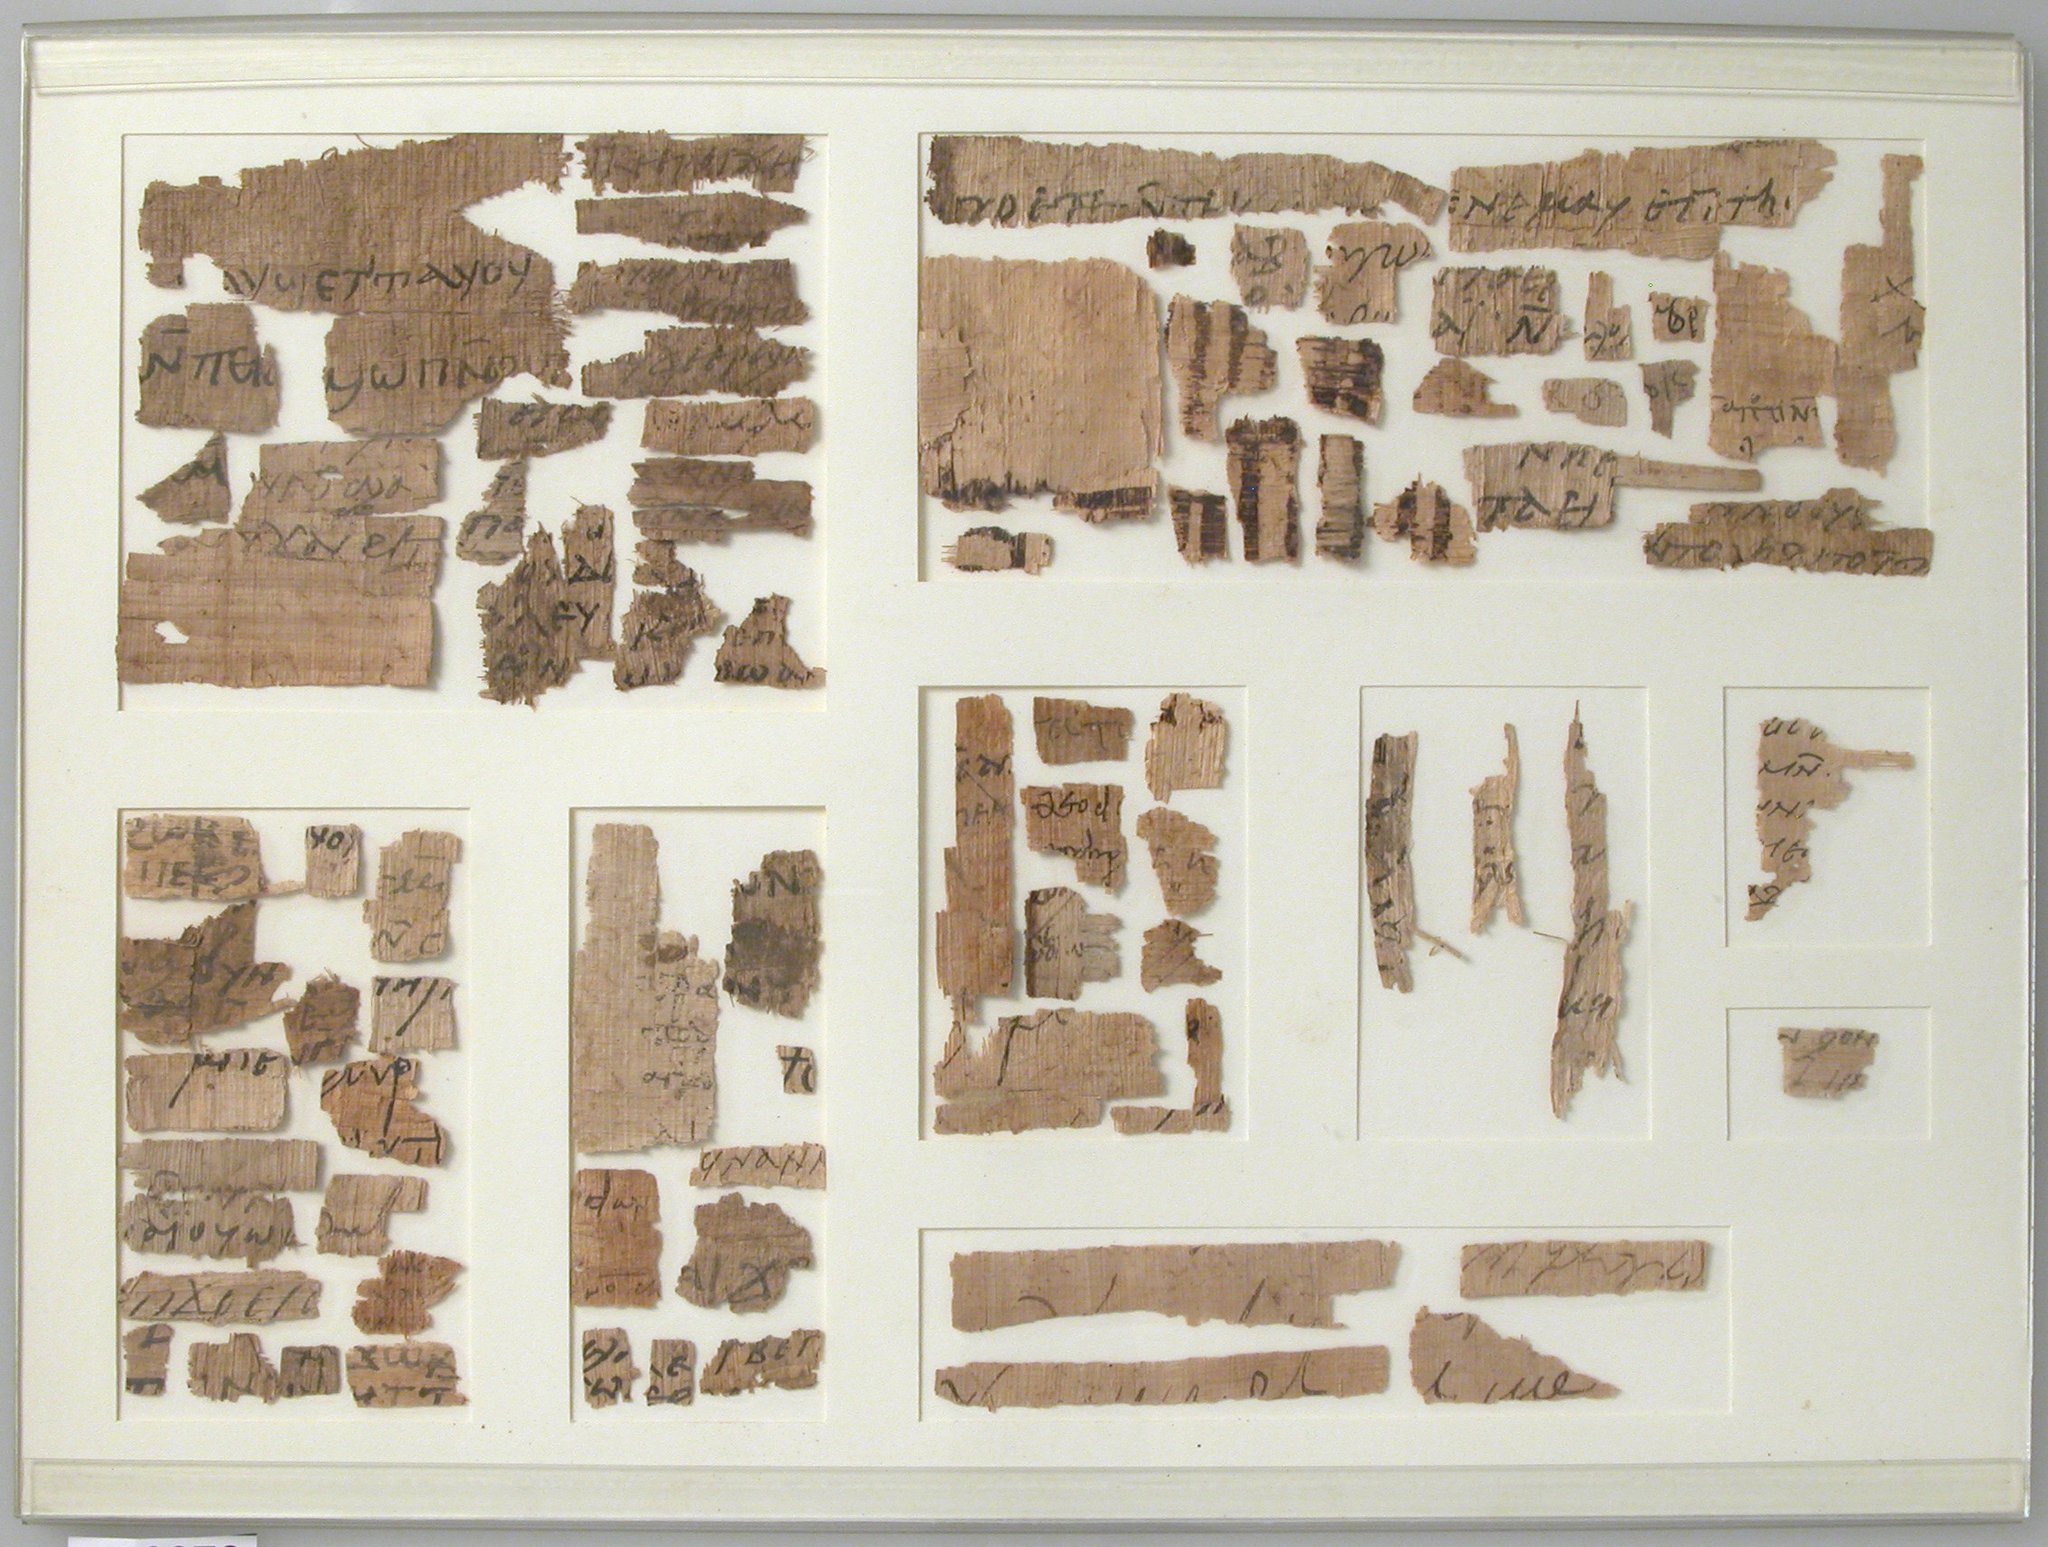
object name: fragment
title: Papyri Fragments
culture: coptic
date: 601-700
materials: ink, papyrus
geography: egypt